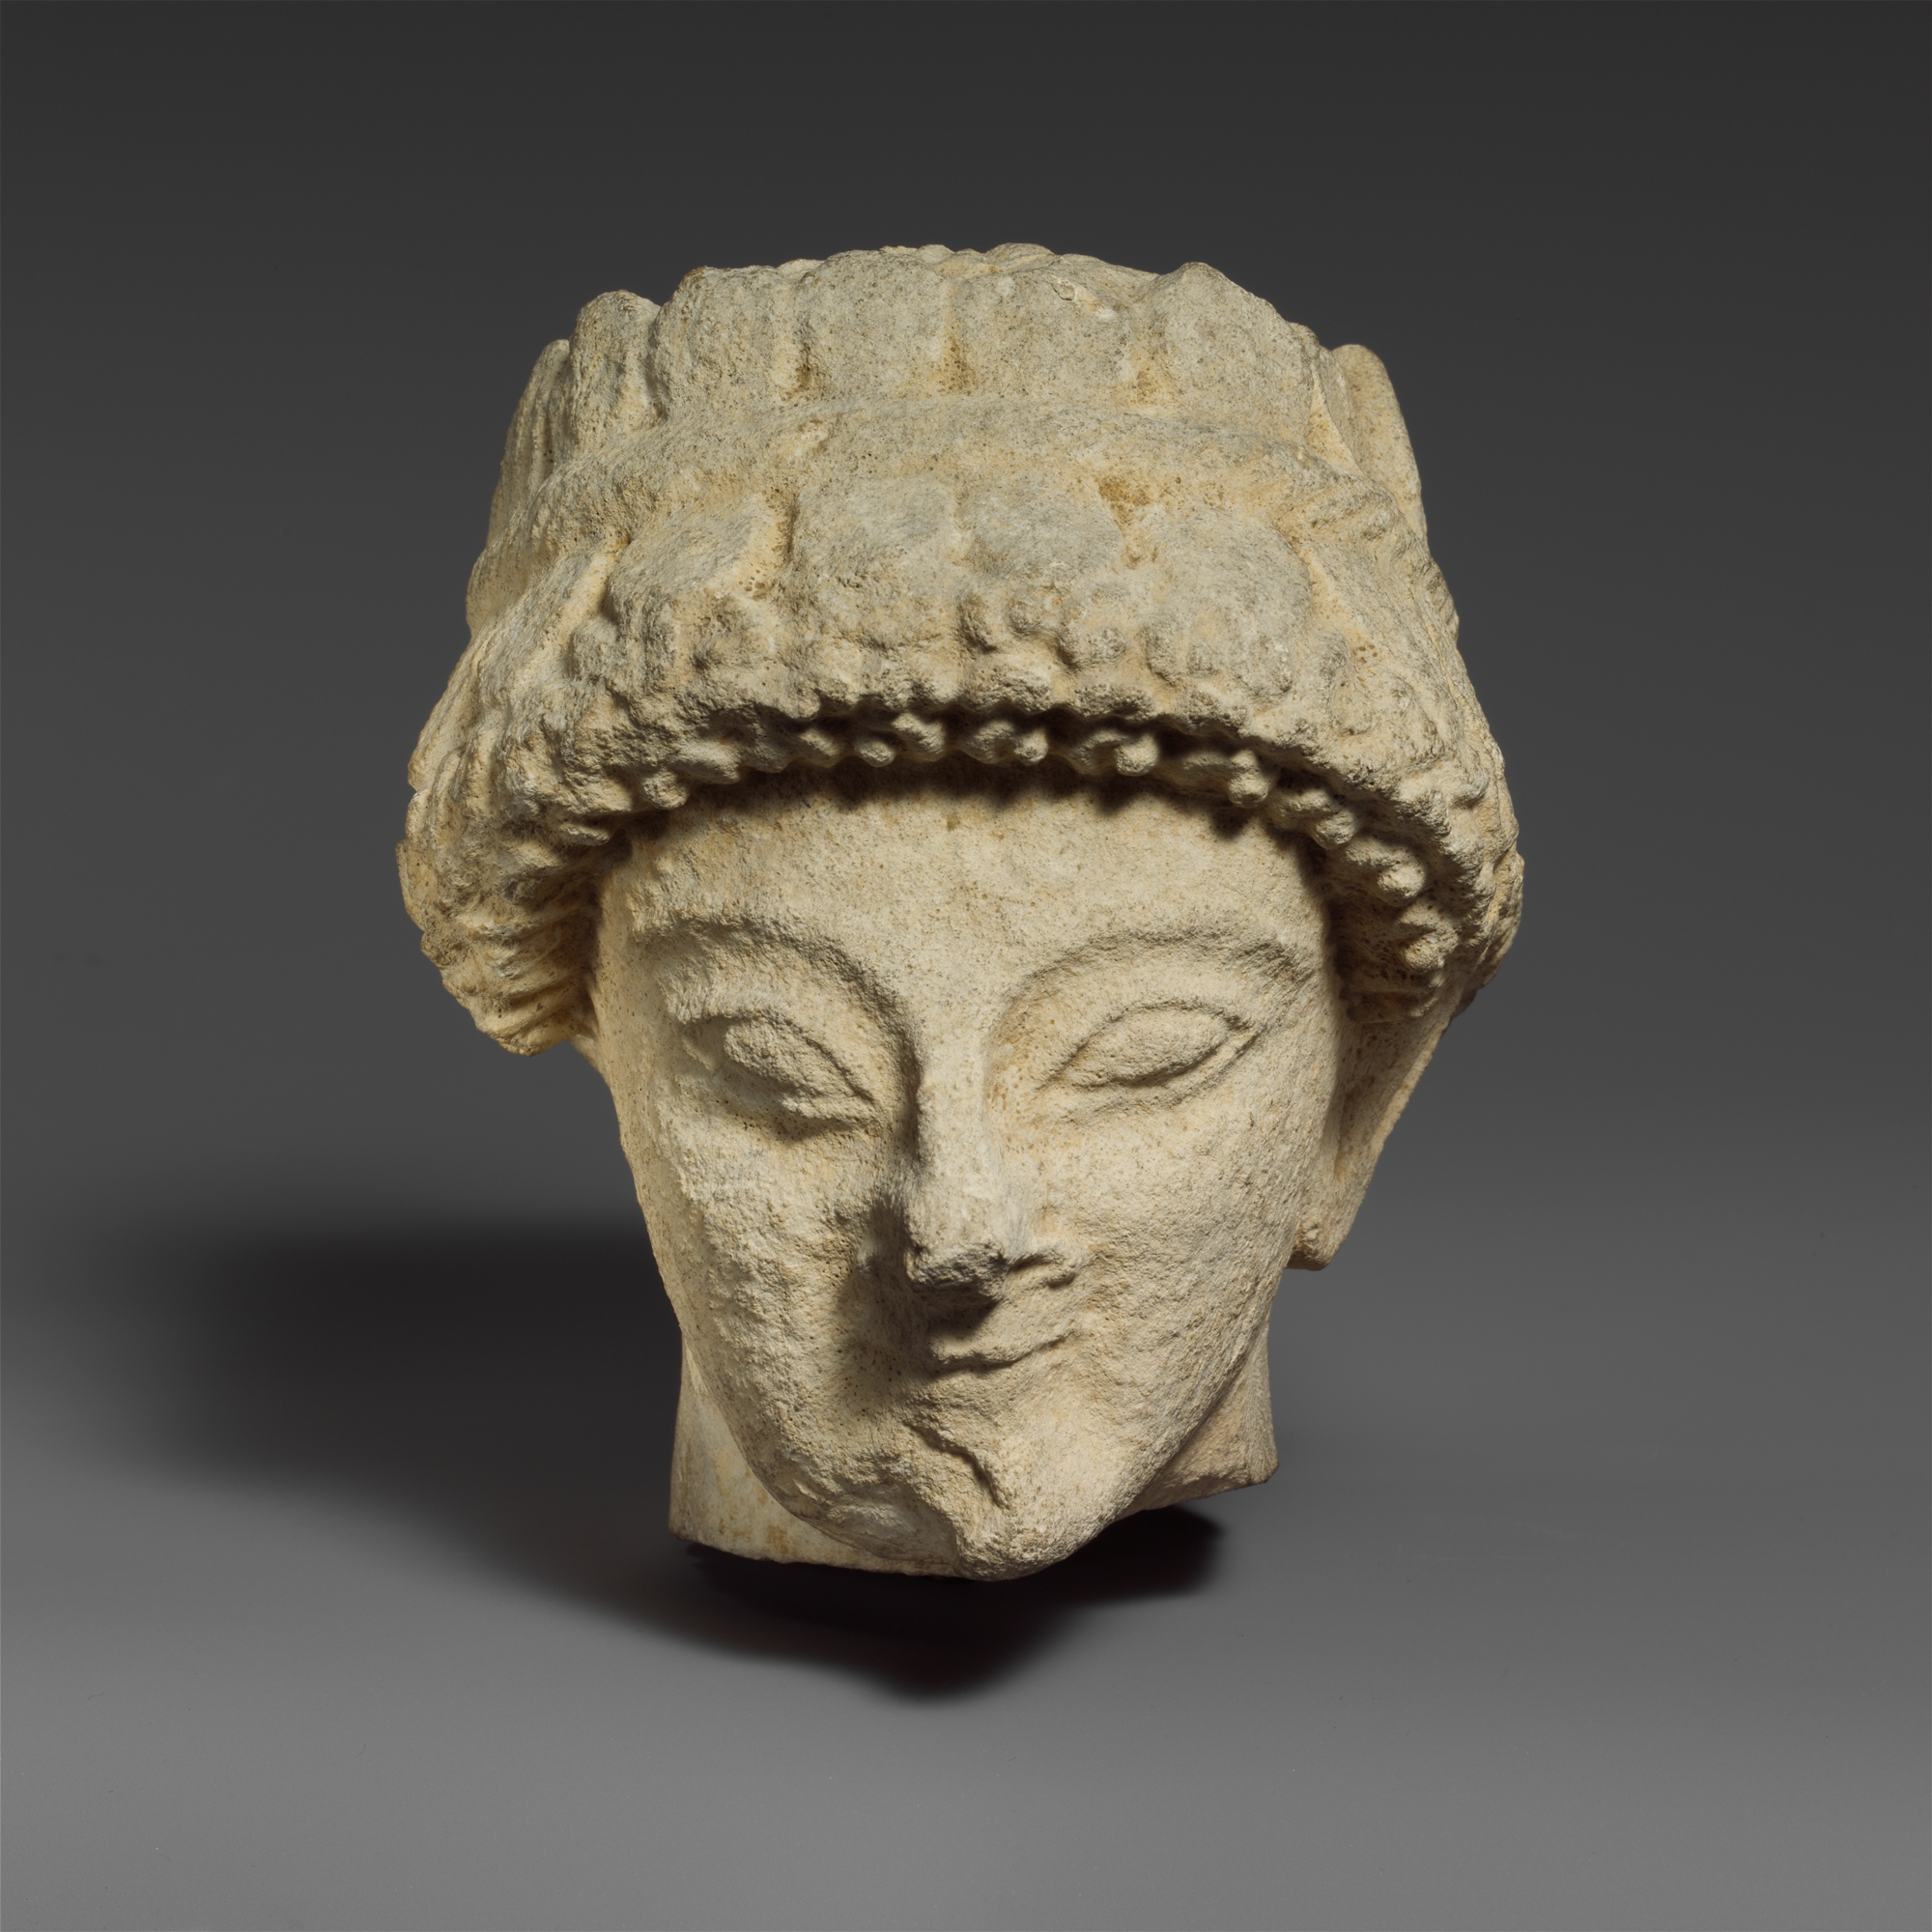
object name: head of a youth with wreath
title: Limestone head with of a beardless male with a wreath of leaves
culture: cypriot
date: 500-468 BCE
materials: limestone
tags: heads,men,wreaths